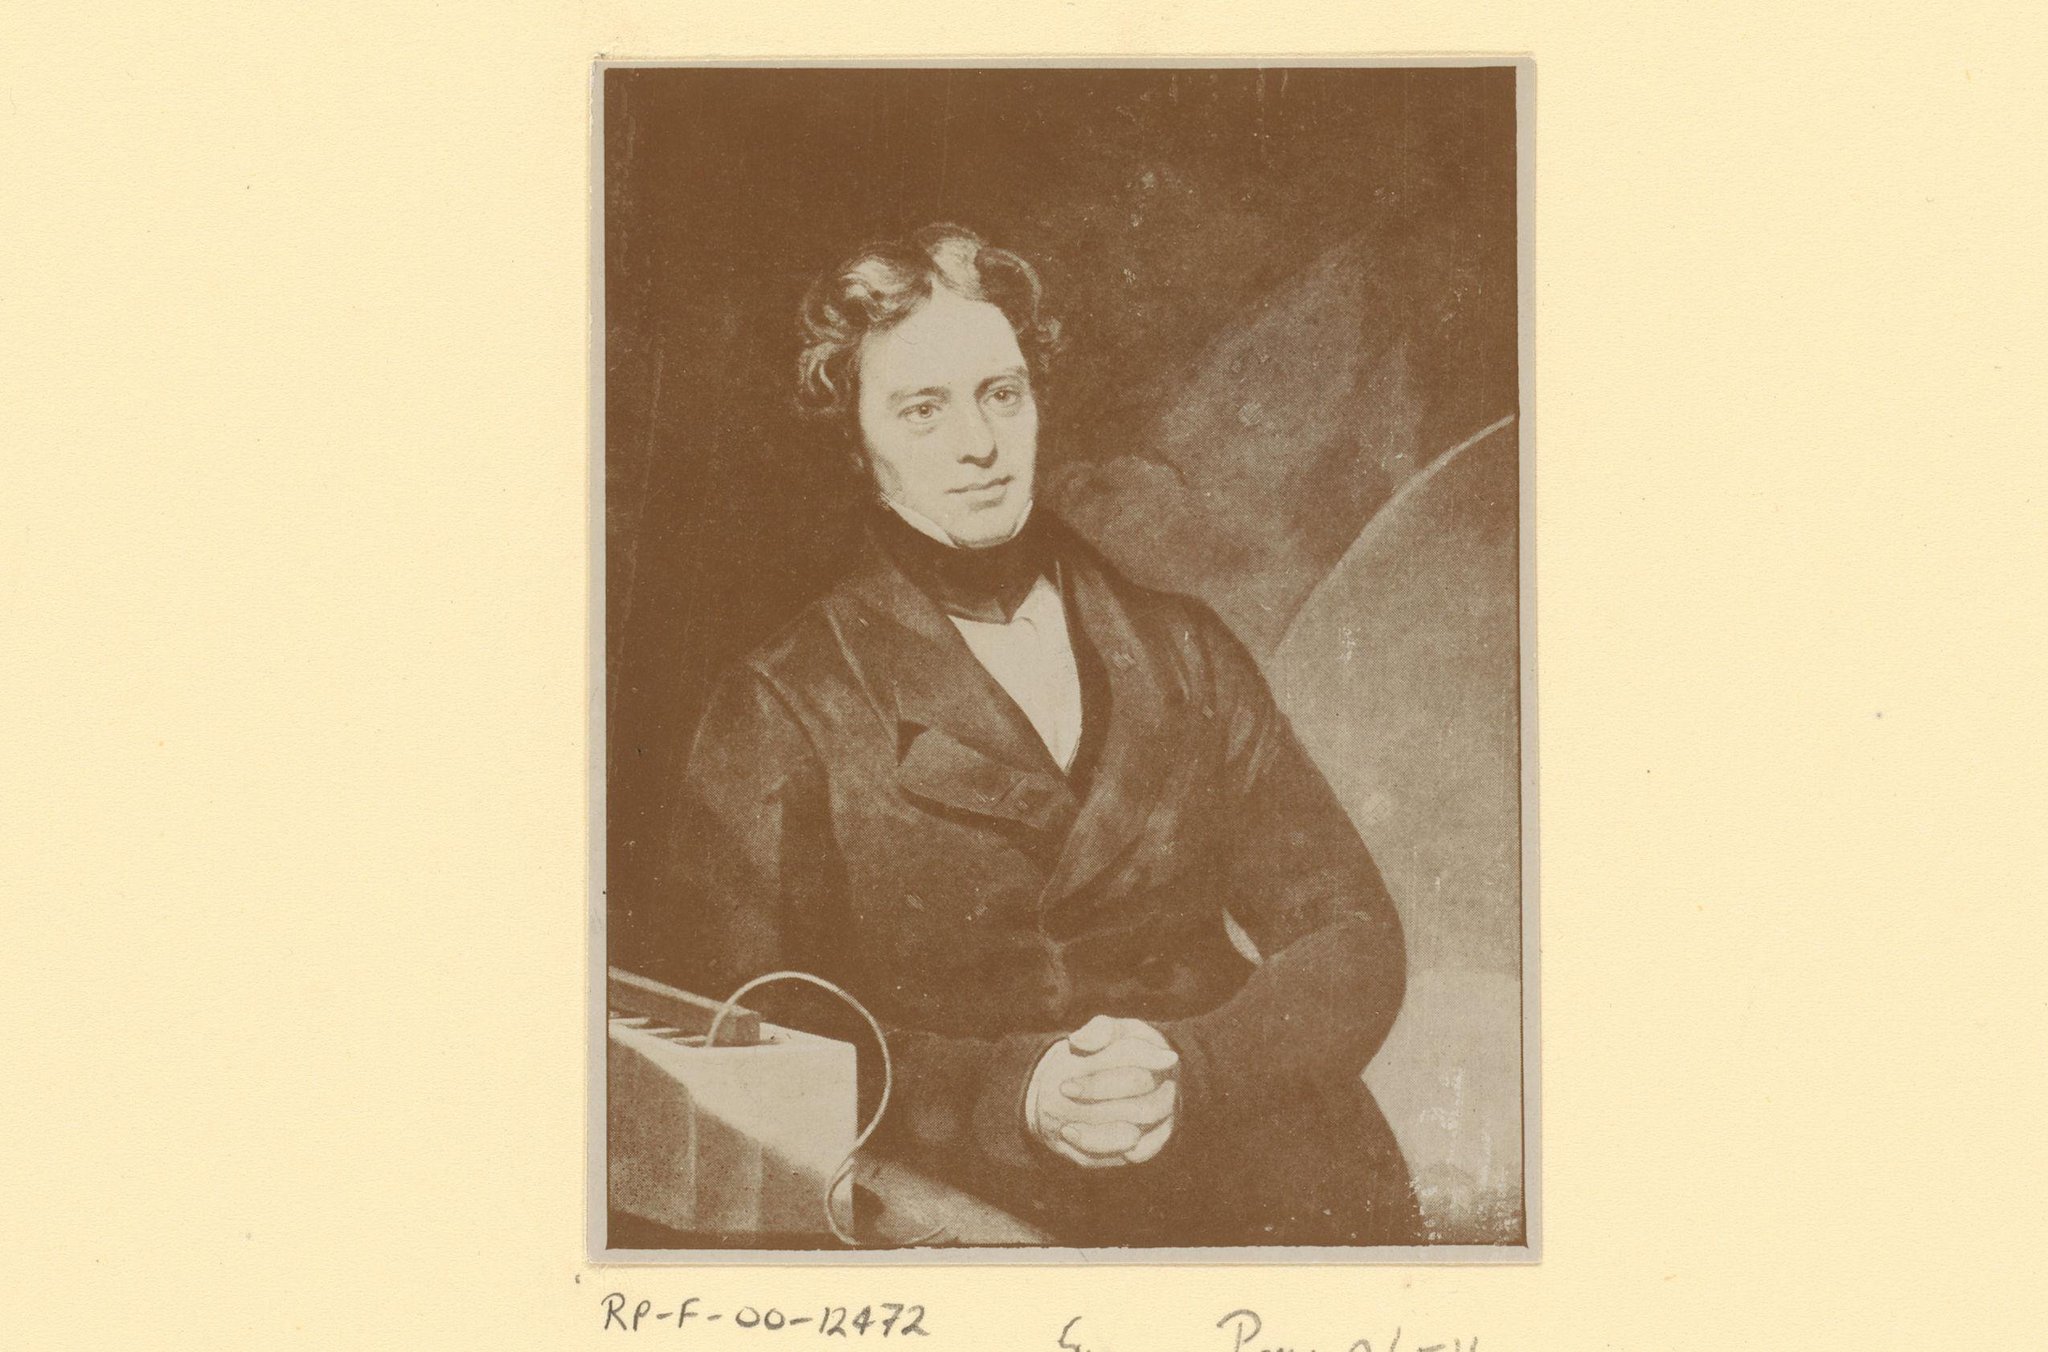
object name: photograph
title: Fotoreproductie van een autotypie van een geschilderd portret van Michael Faraday, door Thomas Phillips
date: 1890-1920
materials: paper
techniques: gelatin silver print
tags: historical persons